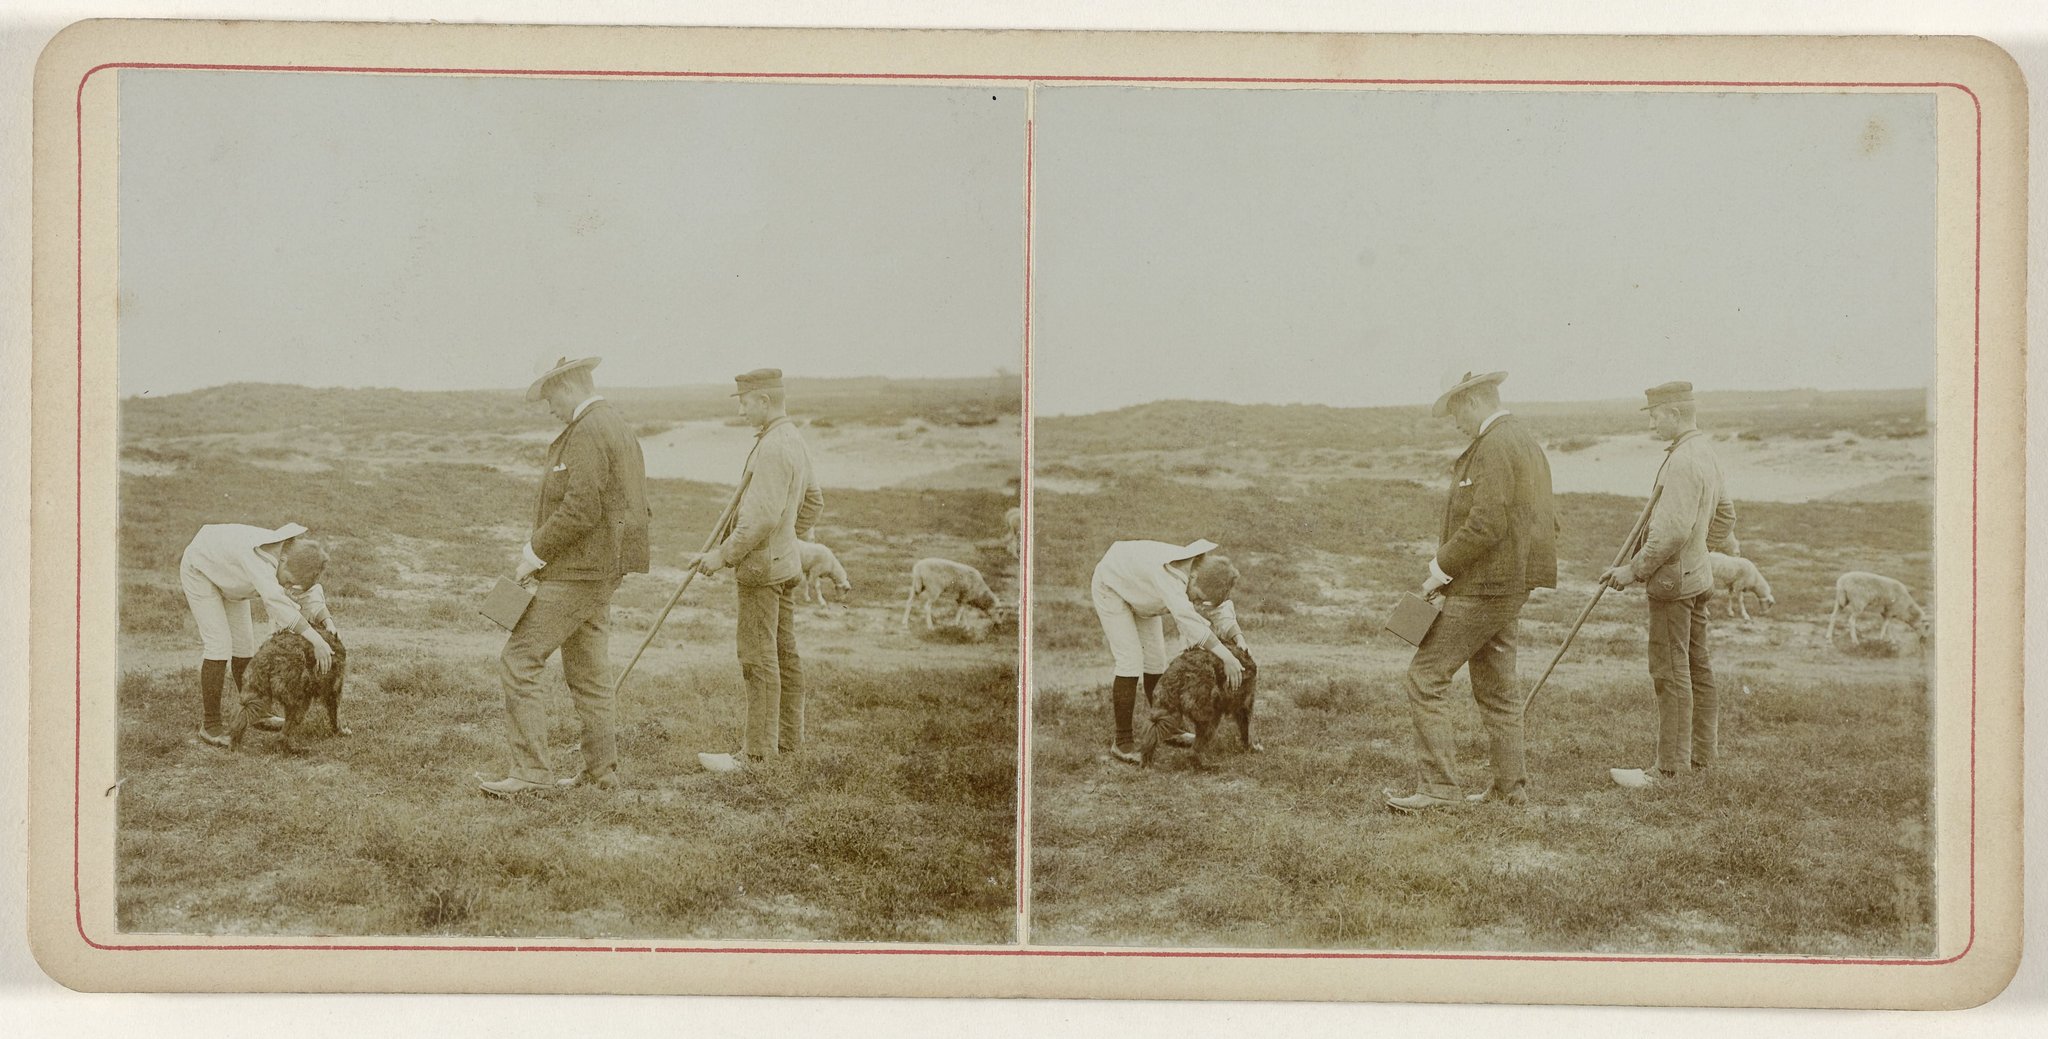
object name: stereograph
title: Groepsportret op de heide tussen de schapen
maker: geldolph adriaan kessler (dolph)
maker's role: fotograaf, industrieel, voetballer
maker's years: 1884-1945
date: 1904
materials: paper, photographic support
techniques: collodion silver print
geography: gelderland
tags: trunk, suit-case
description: Een boer, een jongen in matrozenpak en een man met koffer op de heide tussen de schapen.